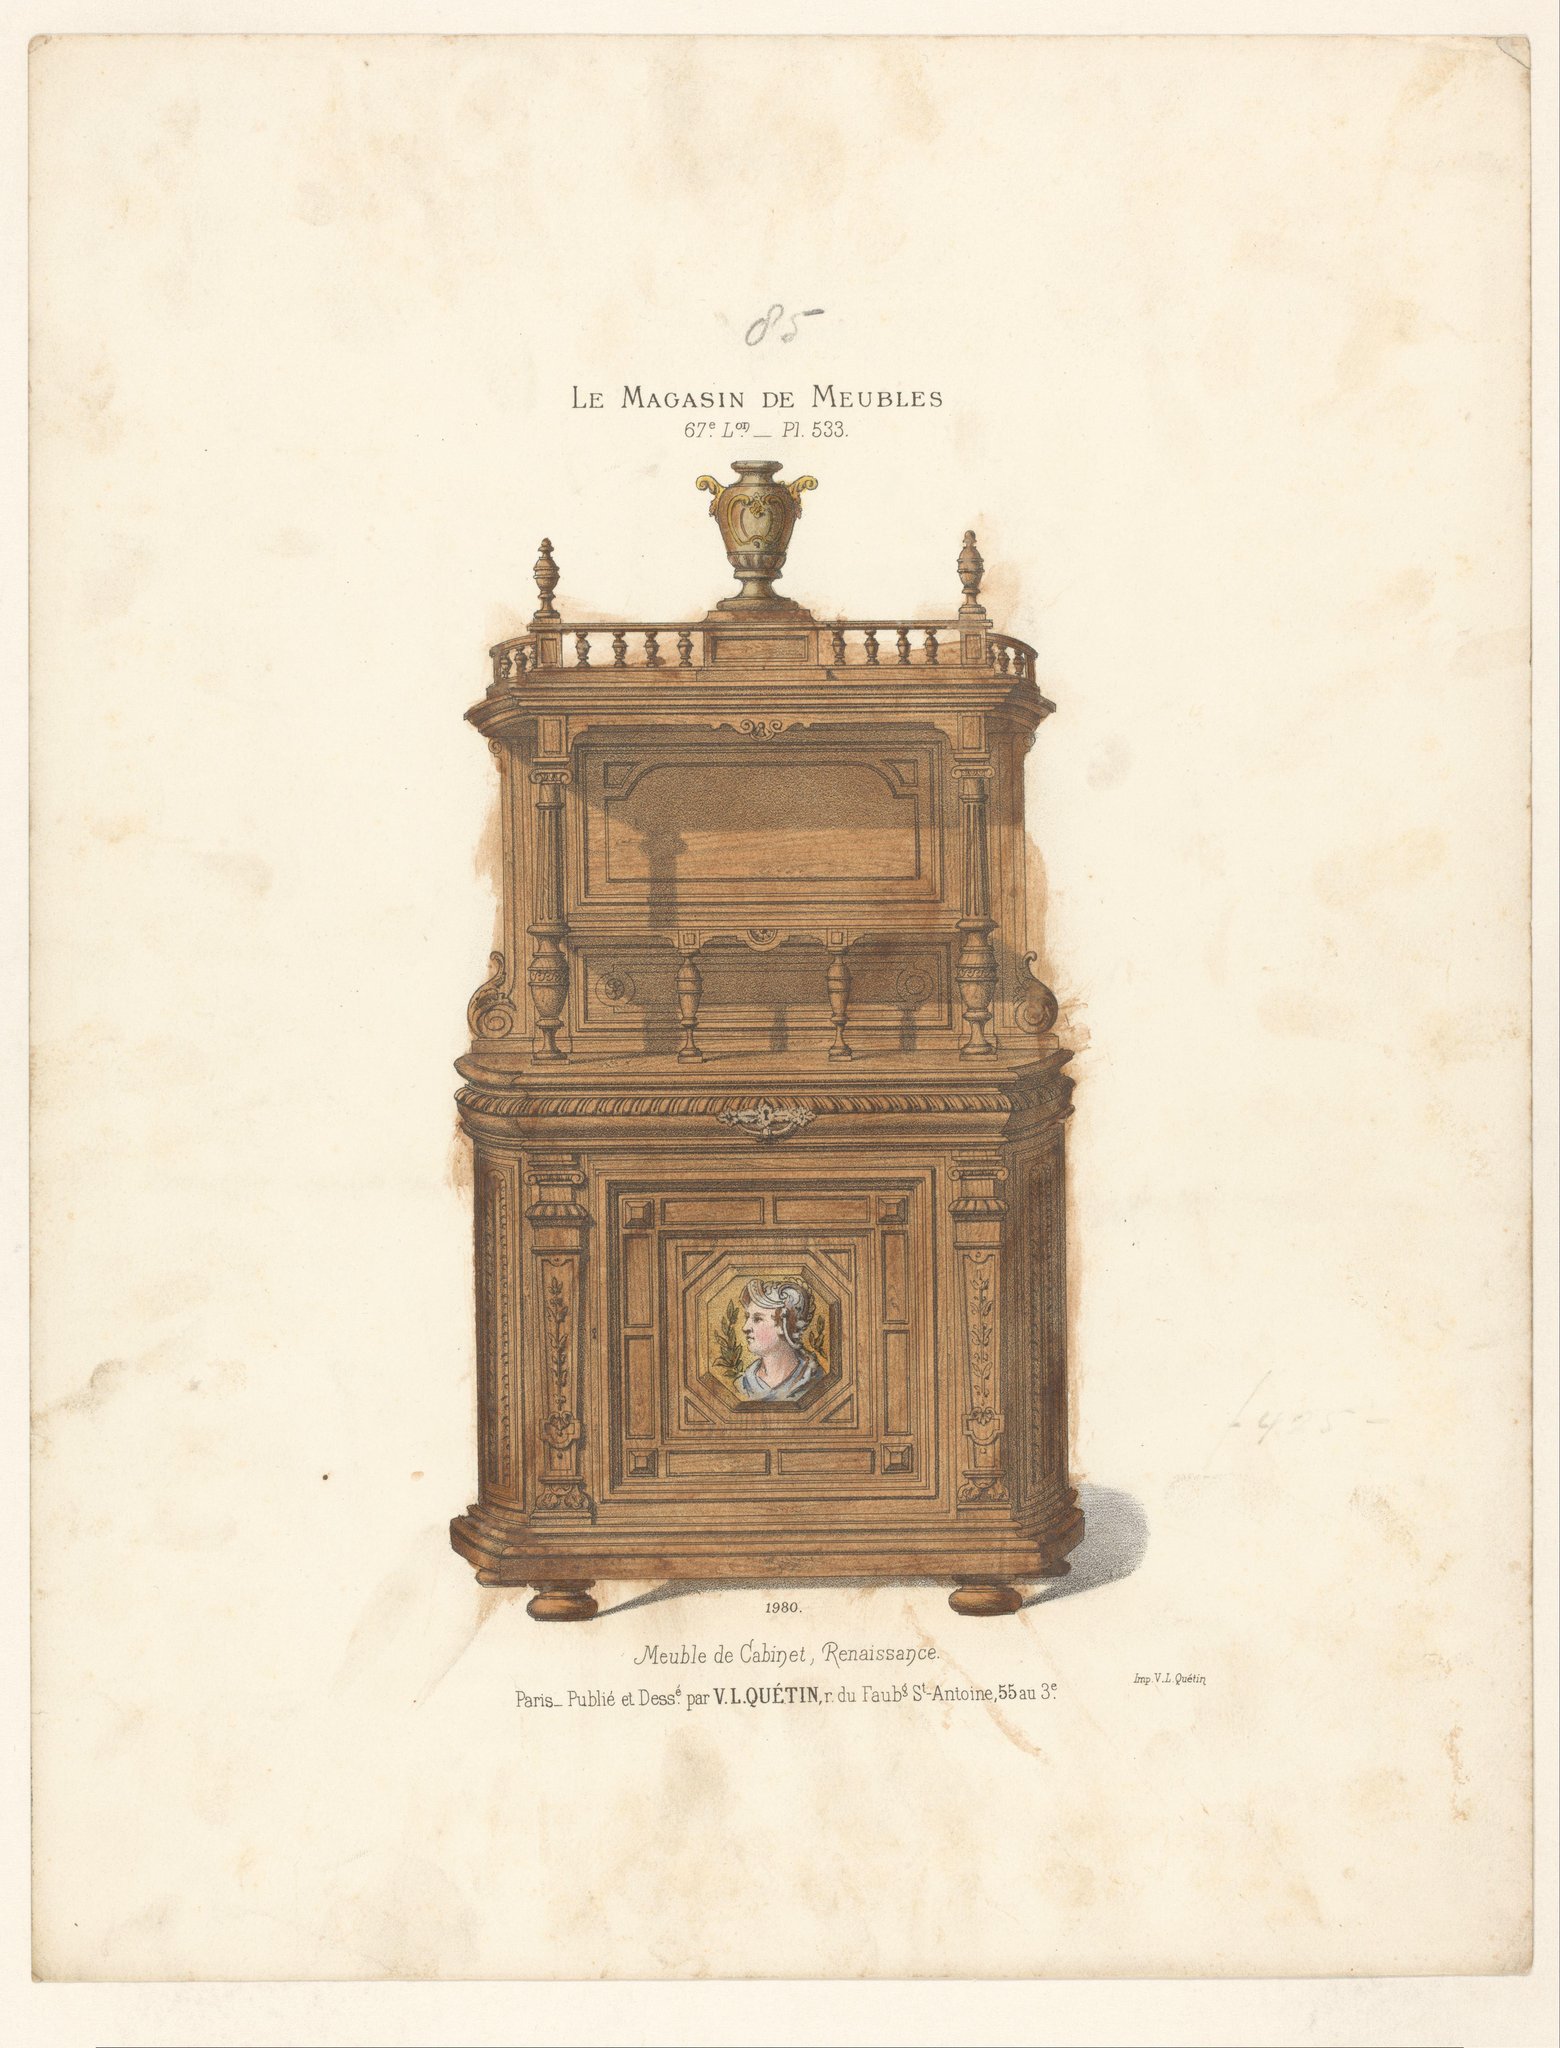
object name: print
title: Le Magasin de Meubles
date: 1878-1904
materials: paper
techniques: hand coloring, lithograph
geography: paris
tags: furniture for storage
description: Een renaissance kast. Prent uit 67e Livraison.